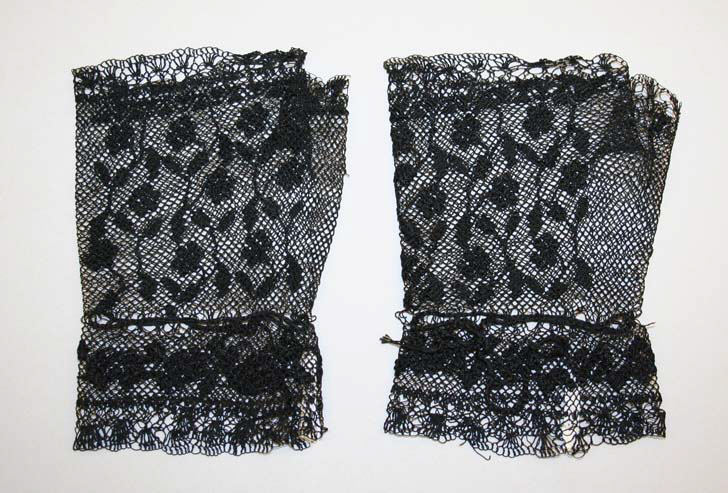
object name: mitt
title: Mitts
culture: american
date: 1874